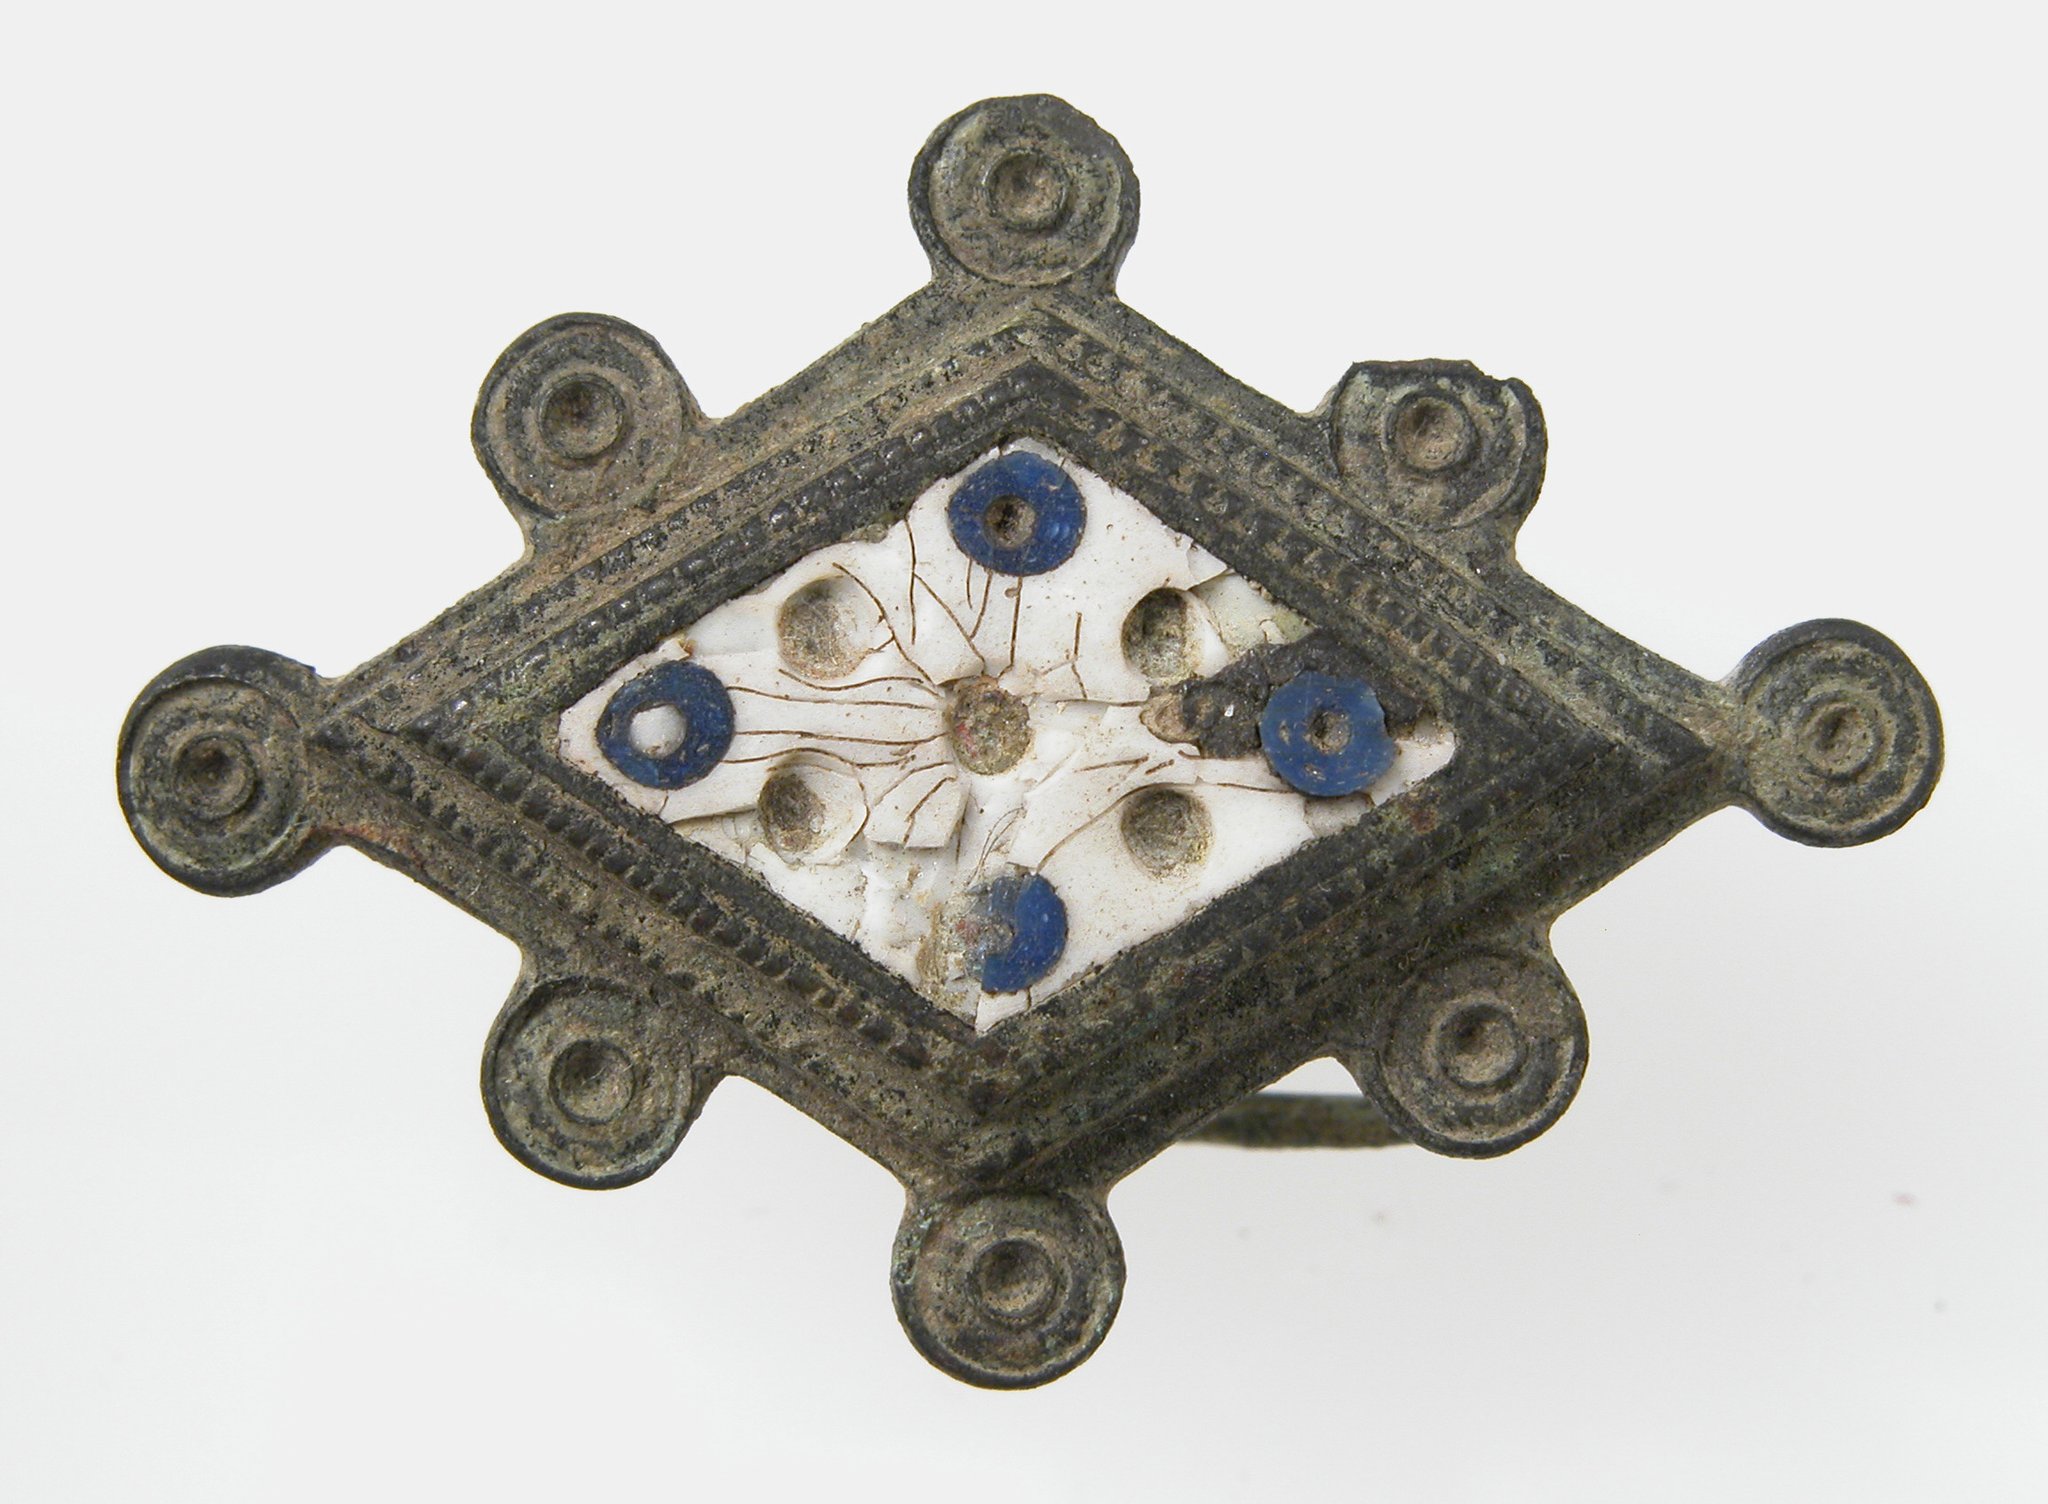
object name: brooch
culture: roman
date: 100-300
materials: bronze, enamel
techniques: enamel